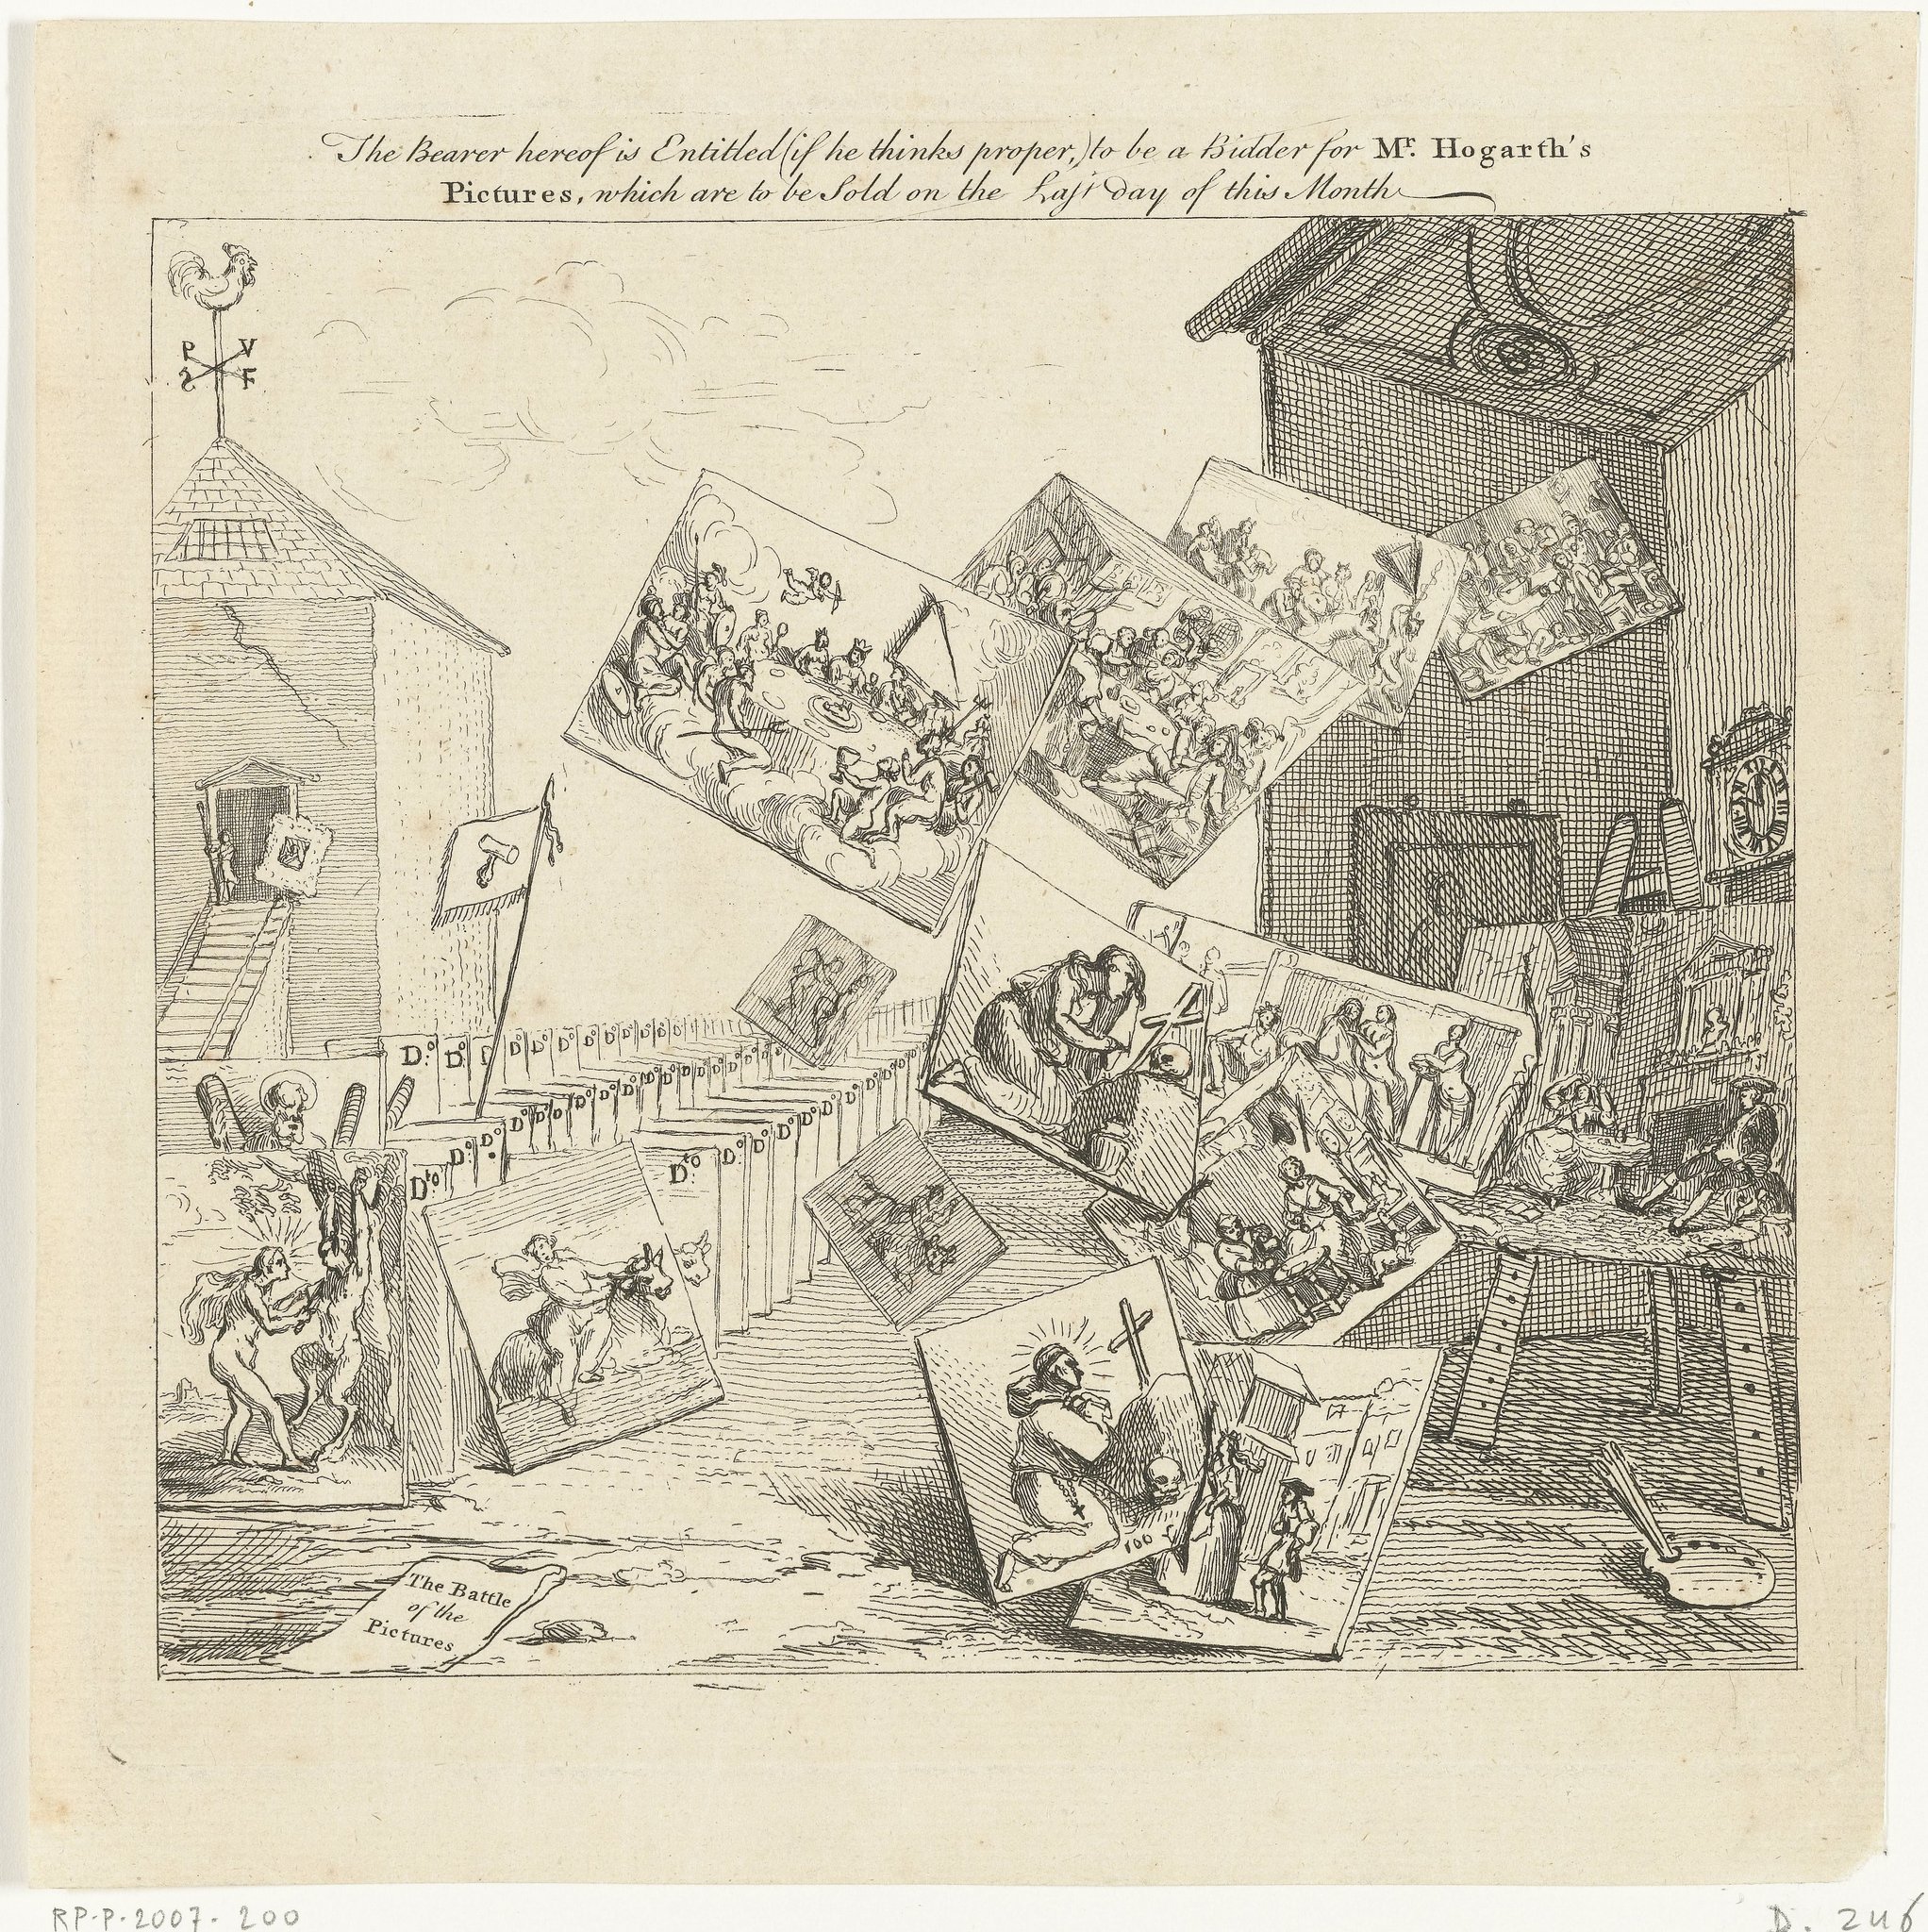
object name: cartoon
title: The Battle of the Pictures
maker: william hogarth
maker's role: draughtsman, painter, print maker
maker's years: 1697-1764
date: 1744-1745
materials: paper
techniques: etching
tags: refinement, taste, picture, painting, political caricatures and satires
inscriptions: collector's mark: Lugt 2228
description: Deze prent is de toegangskaart voor een veiling bij Cock's veilinghuis in 1745. De negentien schilderijen door Hogarth die hier verkocht werden kwamen uit de series 'A Harlot's Progress', 'A Rake's Progress', 'The Four Times of Day' en 'Strolling Actresses Dressing in a Barn'. Deze prent verbeeldt Hogarths anticipatie op een lage opbrengst bij de veiling vanwege de voorkeur van de Britse koper. Dit bleek uiteindelijk ook te kloppen. In deze prent lijken Hogarths prenten inhoudelijk sterker dan de meesterwerken, maar deze winnen uiteindelijk in kwantiteit: links staan drie rijen 'oude meesters' paraat om de aanval voort te zetten. 'Dto' op de hoeken staat voor 'idem dito', duidend op gelijksoortige kunstwerken.